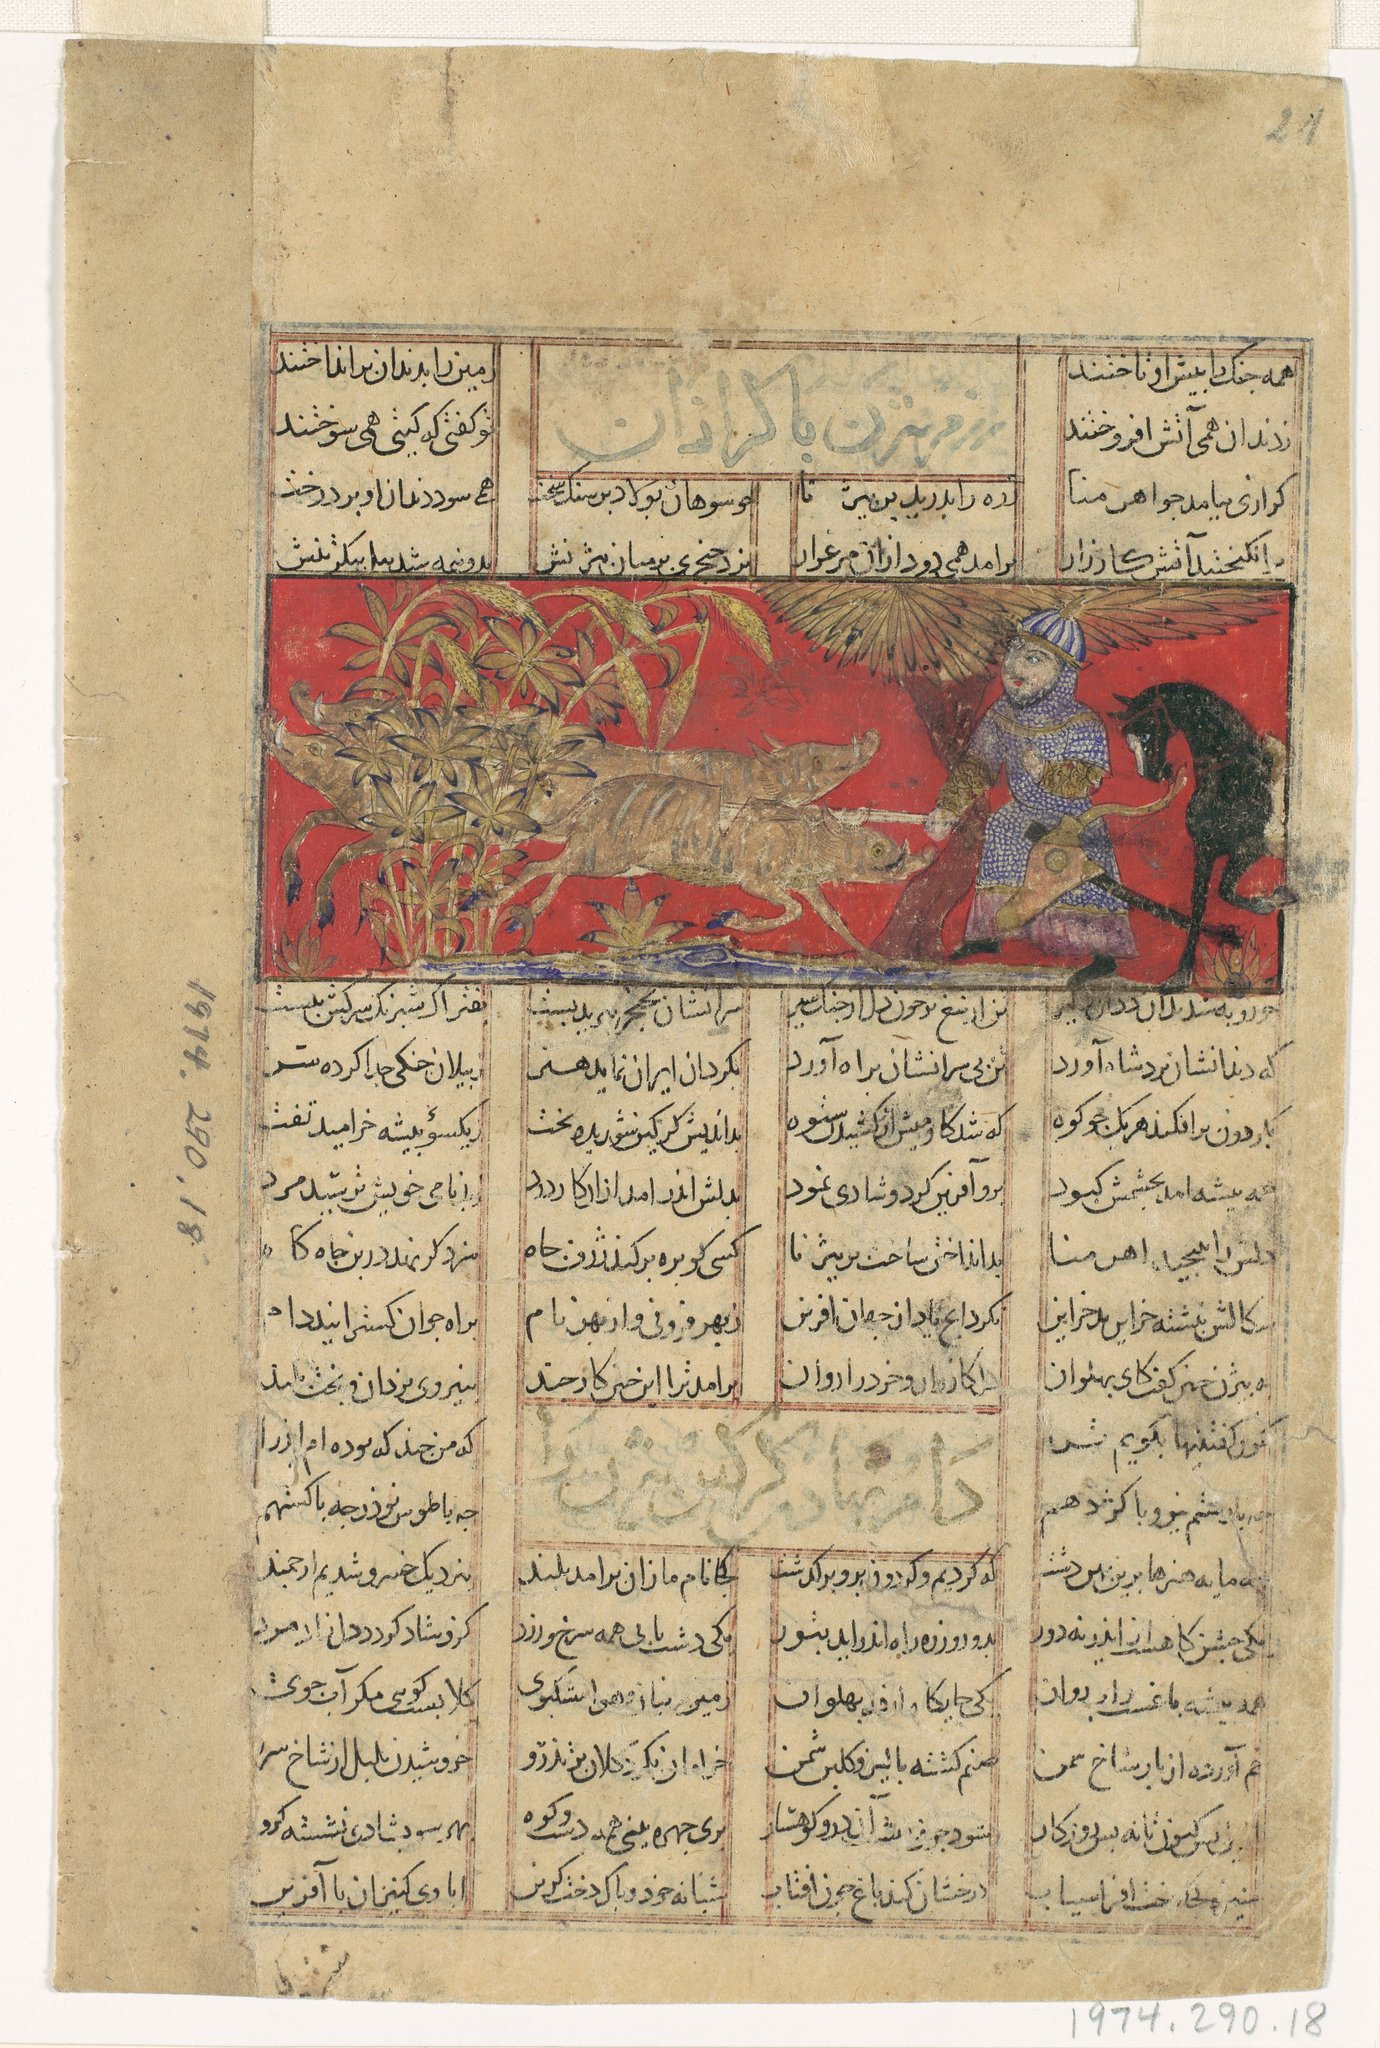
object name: folio from an illustrated manuscript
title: "Bizhan Slaughters the Wild Boars of Irman", Folio from a Shahnama (Book of Kings) of Firdausi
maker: abu'l qasim firdausi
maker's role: author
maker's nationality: iranian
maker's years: 935-1020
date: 1330-1340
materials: gold, ink, paper, silver, watercolor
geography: iran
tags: men,boars,horses